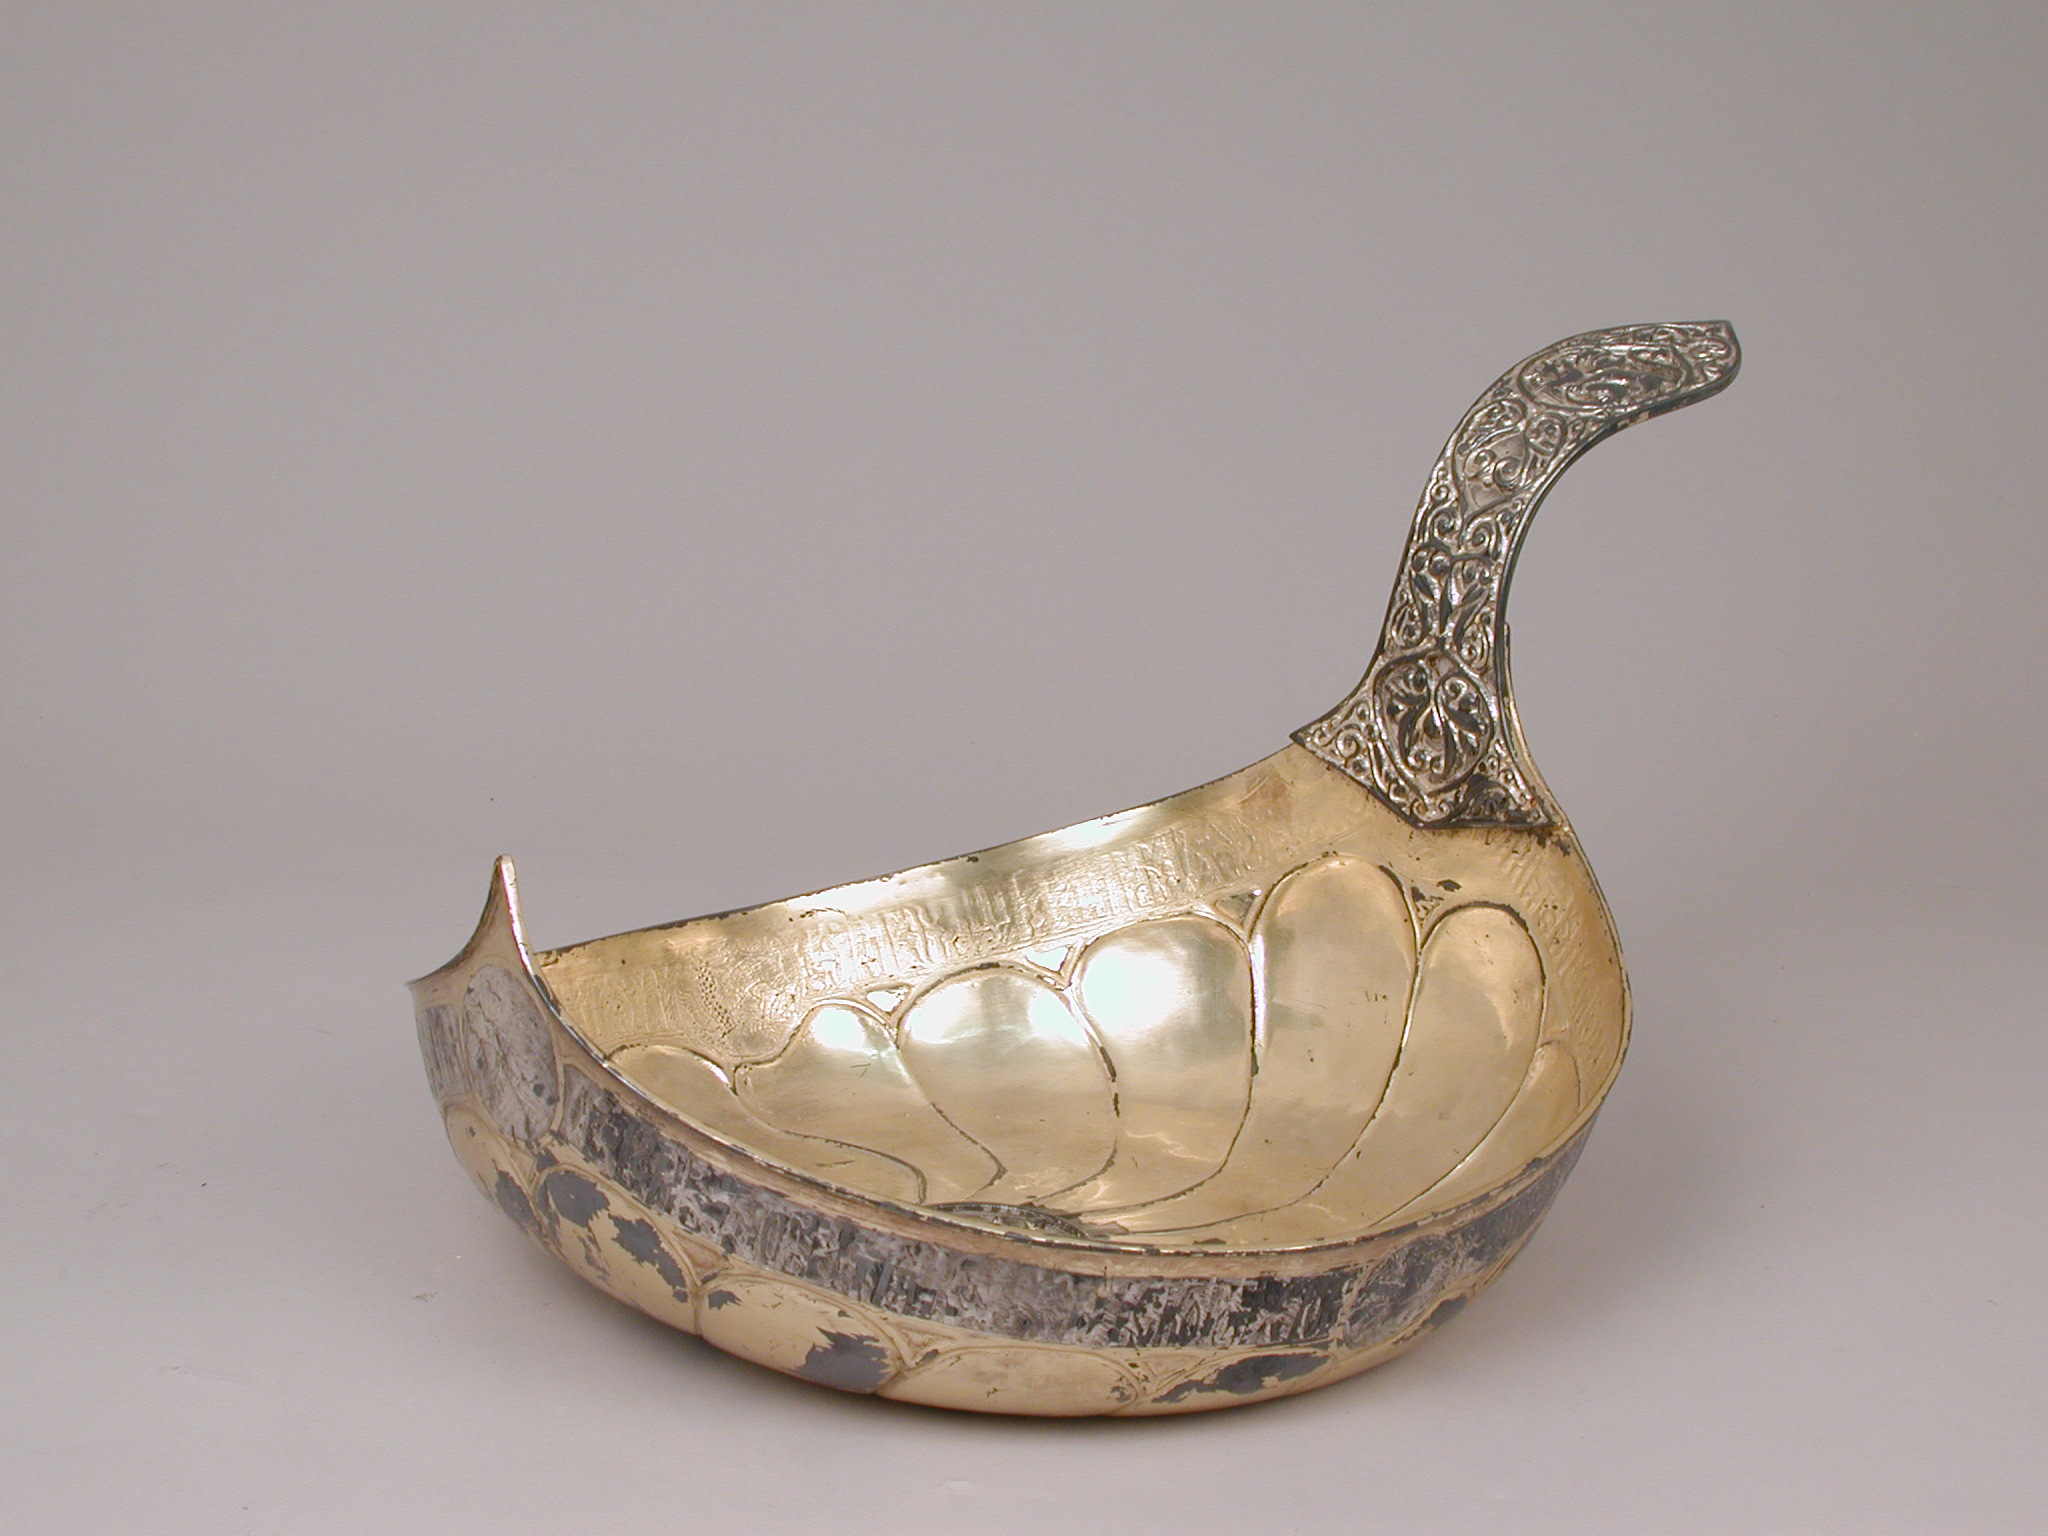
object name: ladle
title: Ladle (Puisoir)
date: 1801-1900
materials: gilt, silver